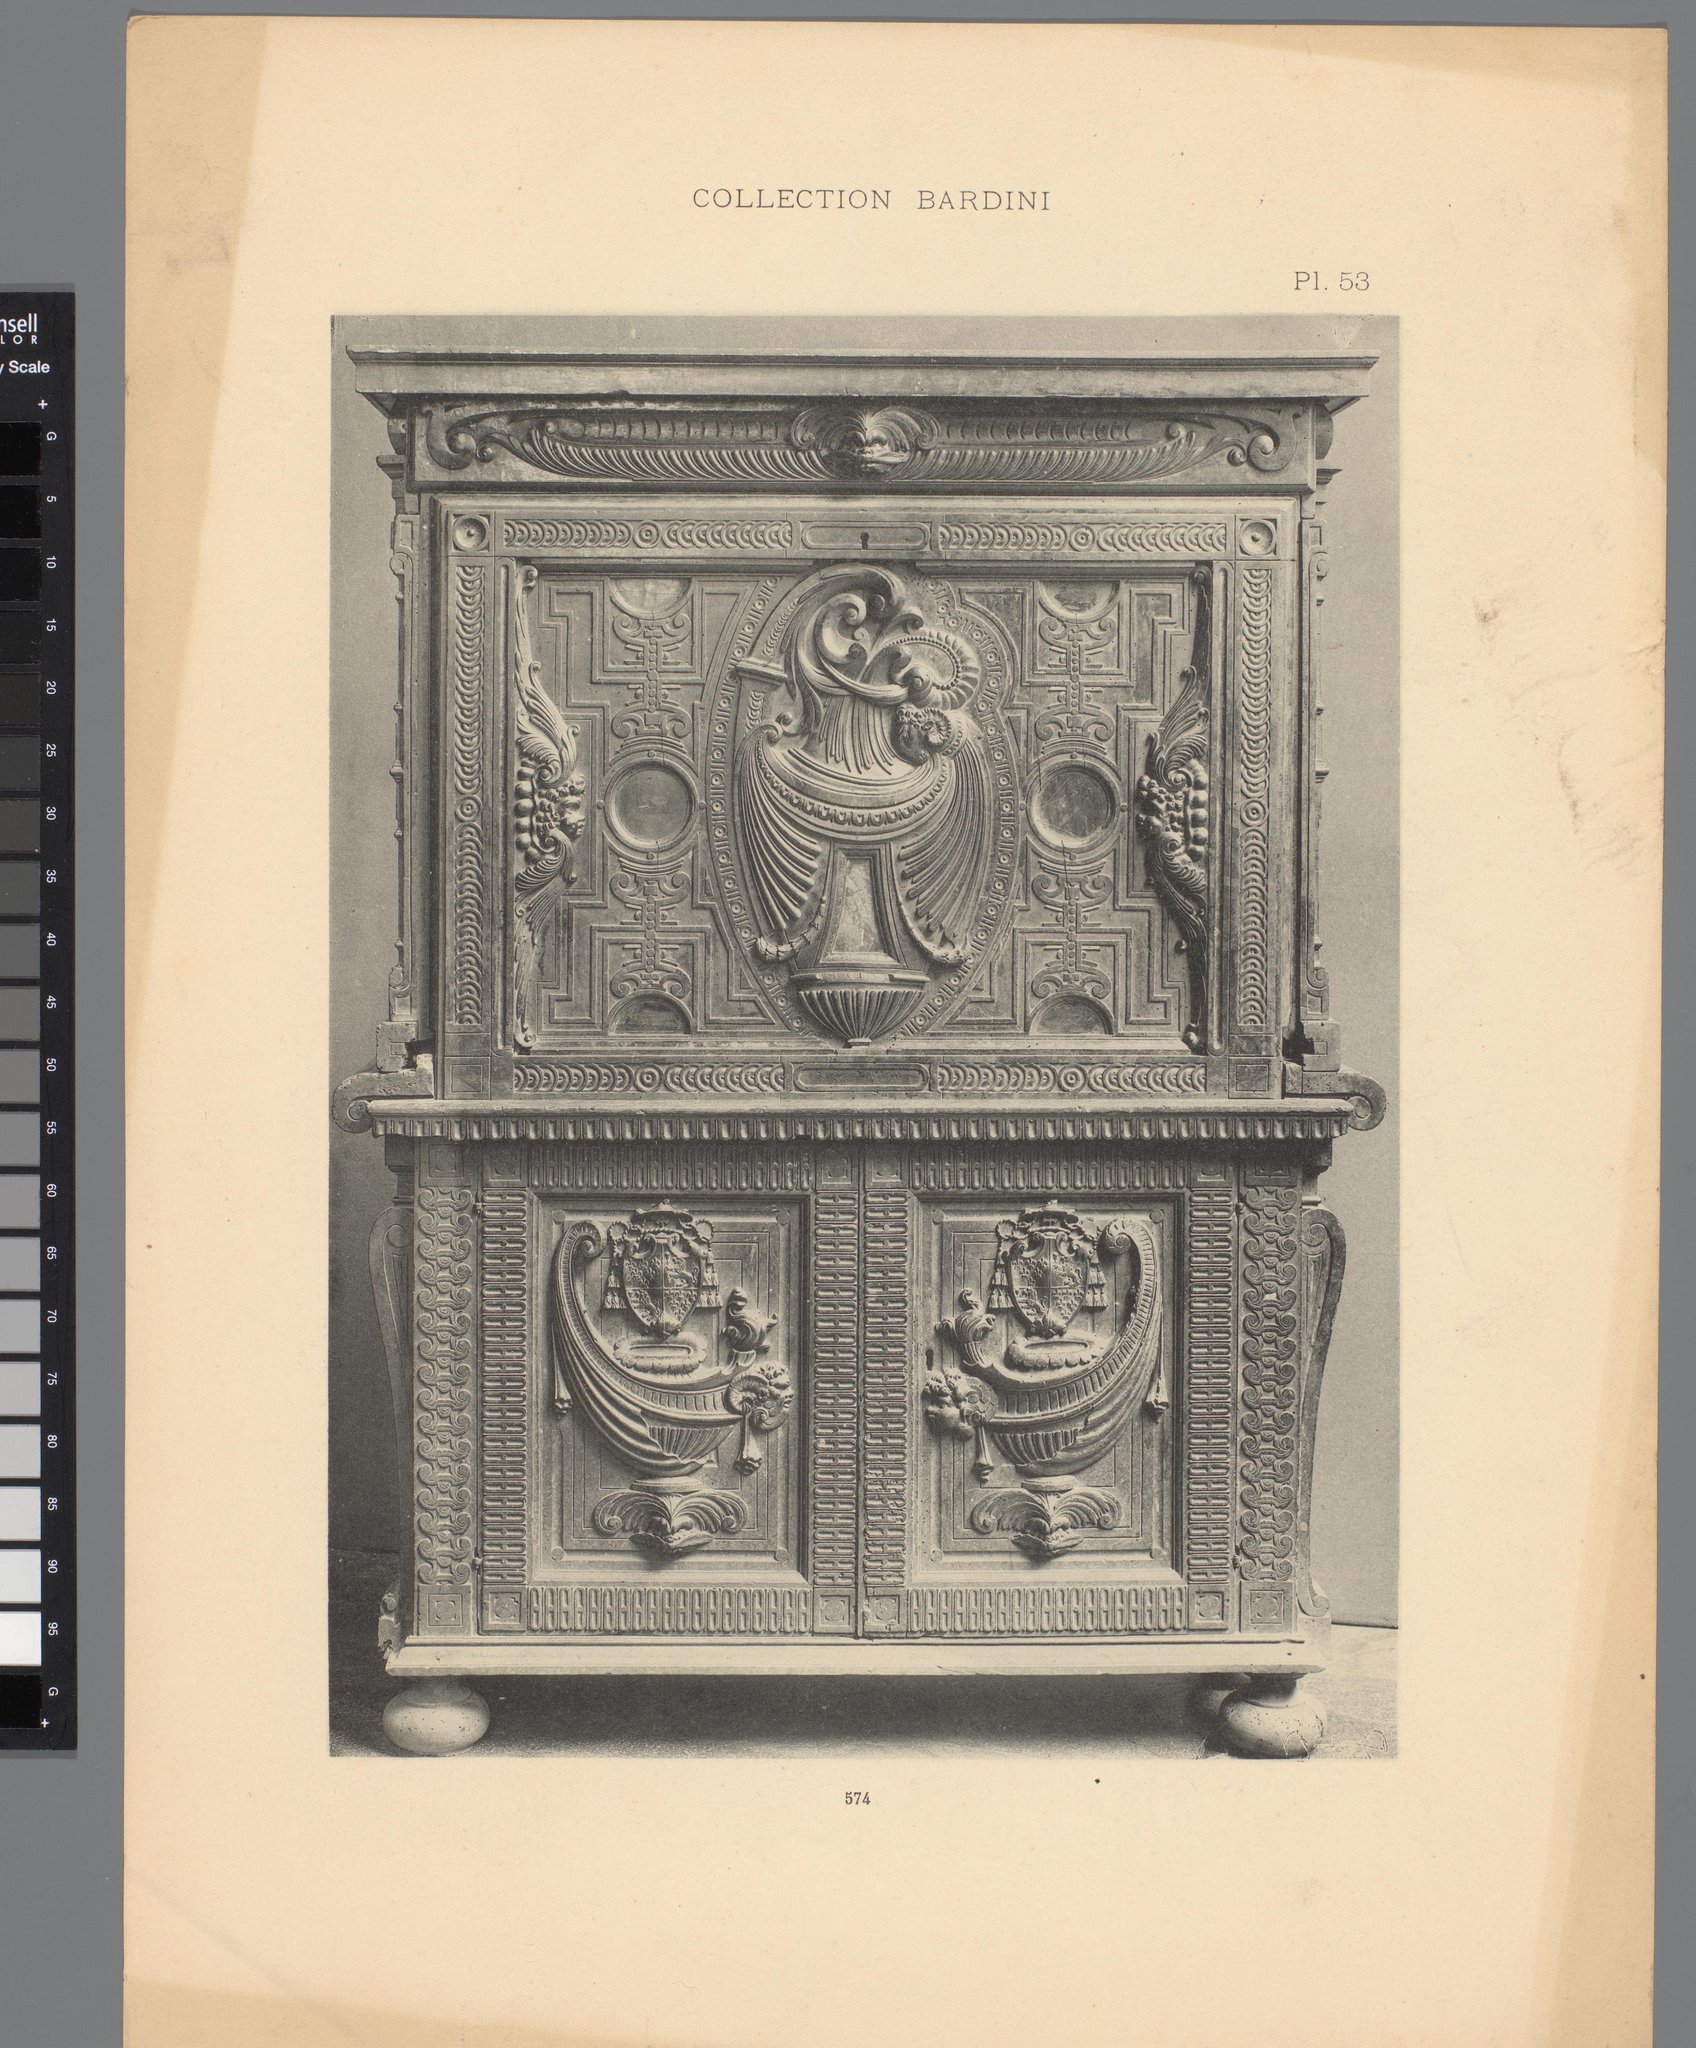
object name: photomechanical print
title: Gedecoreerd kabinet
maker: Anonymous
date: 1875-1930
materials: paper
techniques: photograph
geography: florence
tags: ornamental cupboard (+ wood and other phytogenic material)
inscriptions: number: ‘Pl. 53’